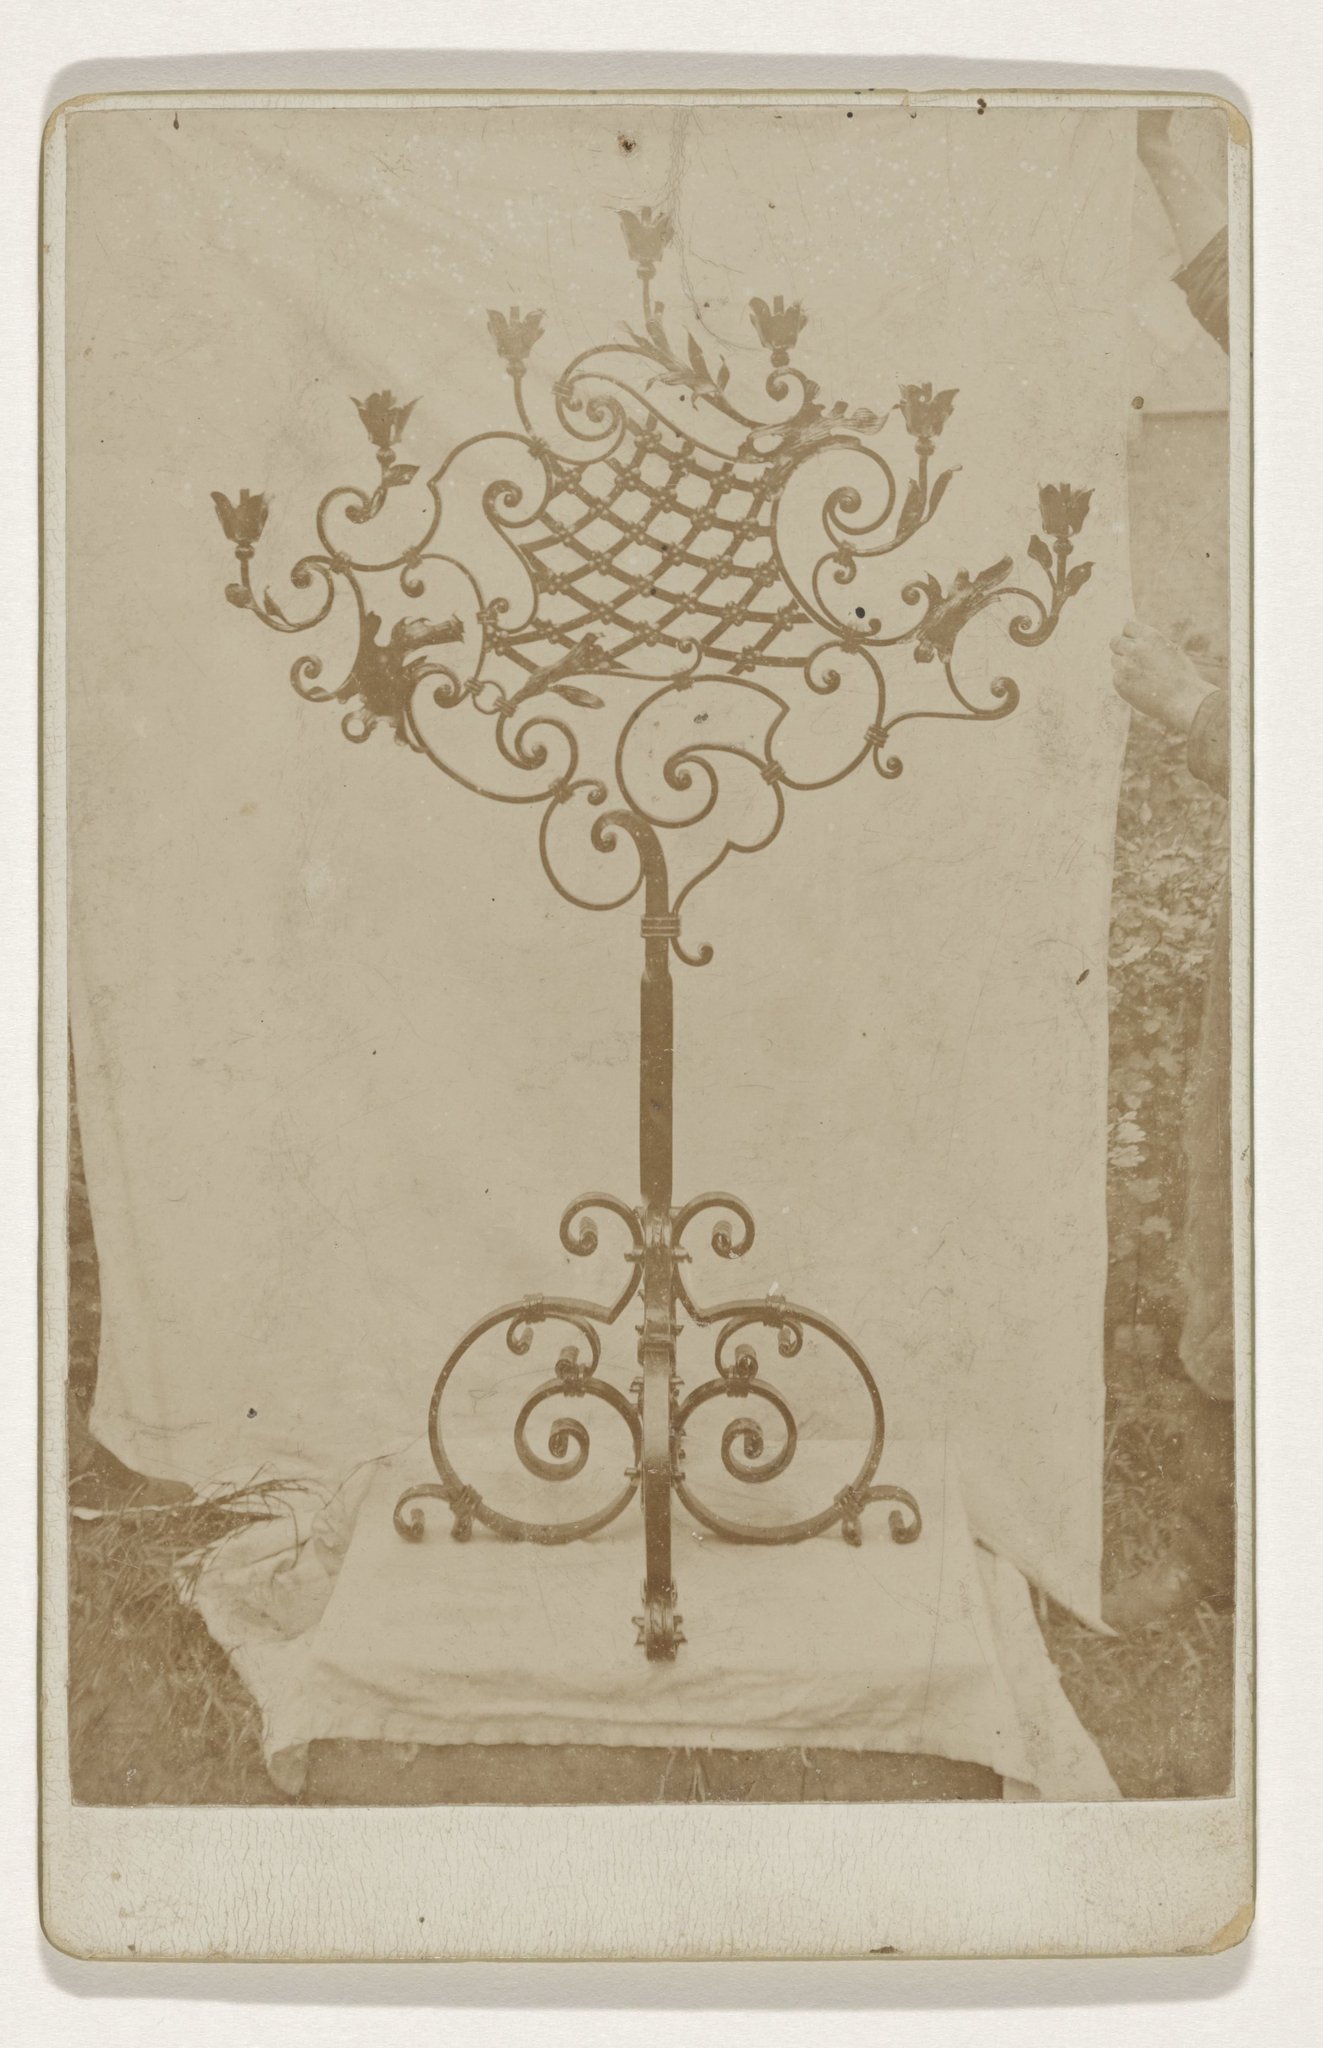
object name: photograph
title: Kandelaar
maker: Anonymous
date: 1870-1890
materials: paper, cardboard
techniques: collodion silver print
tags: candlestick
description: Los albumblad behorend bij fotoalbum met foto's omgeven door pentekeningen.